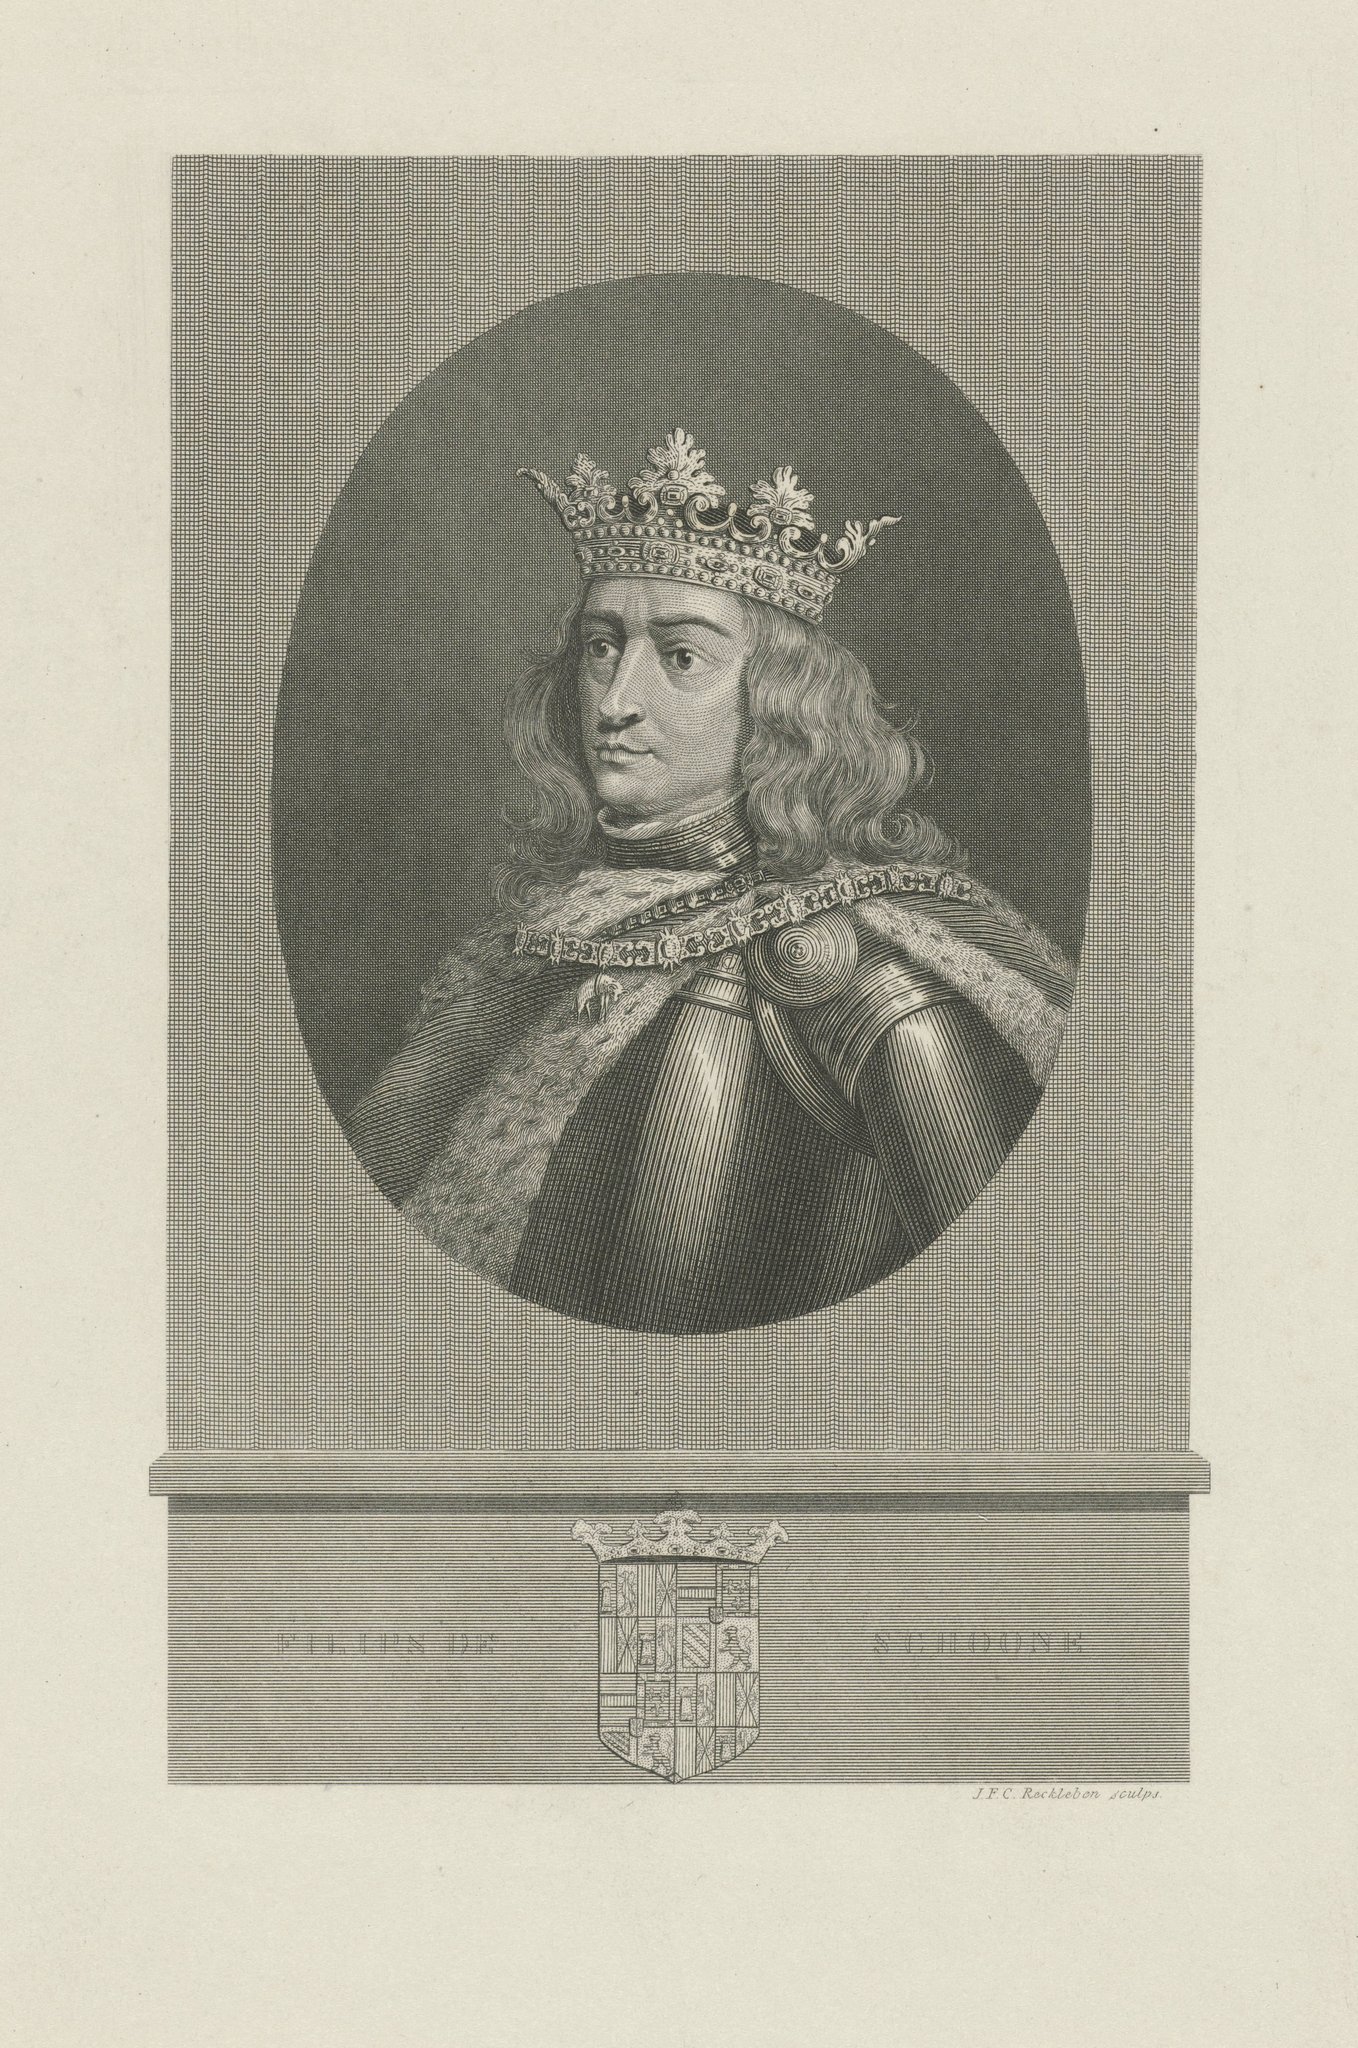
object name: print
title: Portret van Filips de Schone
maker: jan frederik christiaan reckleben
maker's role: print maker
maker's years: 1819-1879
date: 1847-1849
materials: paper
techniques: engraving, etching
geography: amsterdam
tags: bruges, philip iii the good, knighthood order of the golden fleece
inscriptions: collector's mark: Lugt 2228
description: Illustratie in: Arend, Johannes Pieter. Algemeene geschiedenis des vaderlands van de vroegste tijden tot op heden. 5 delen, Amsterdam: Schleijer, J.F. 1840-1884, dl. 2.3, p. 284.